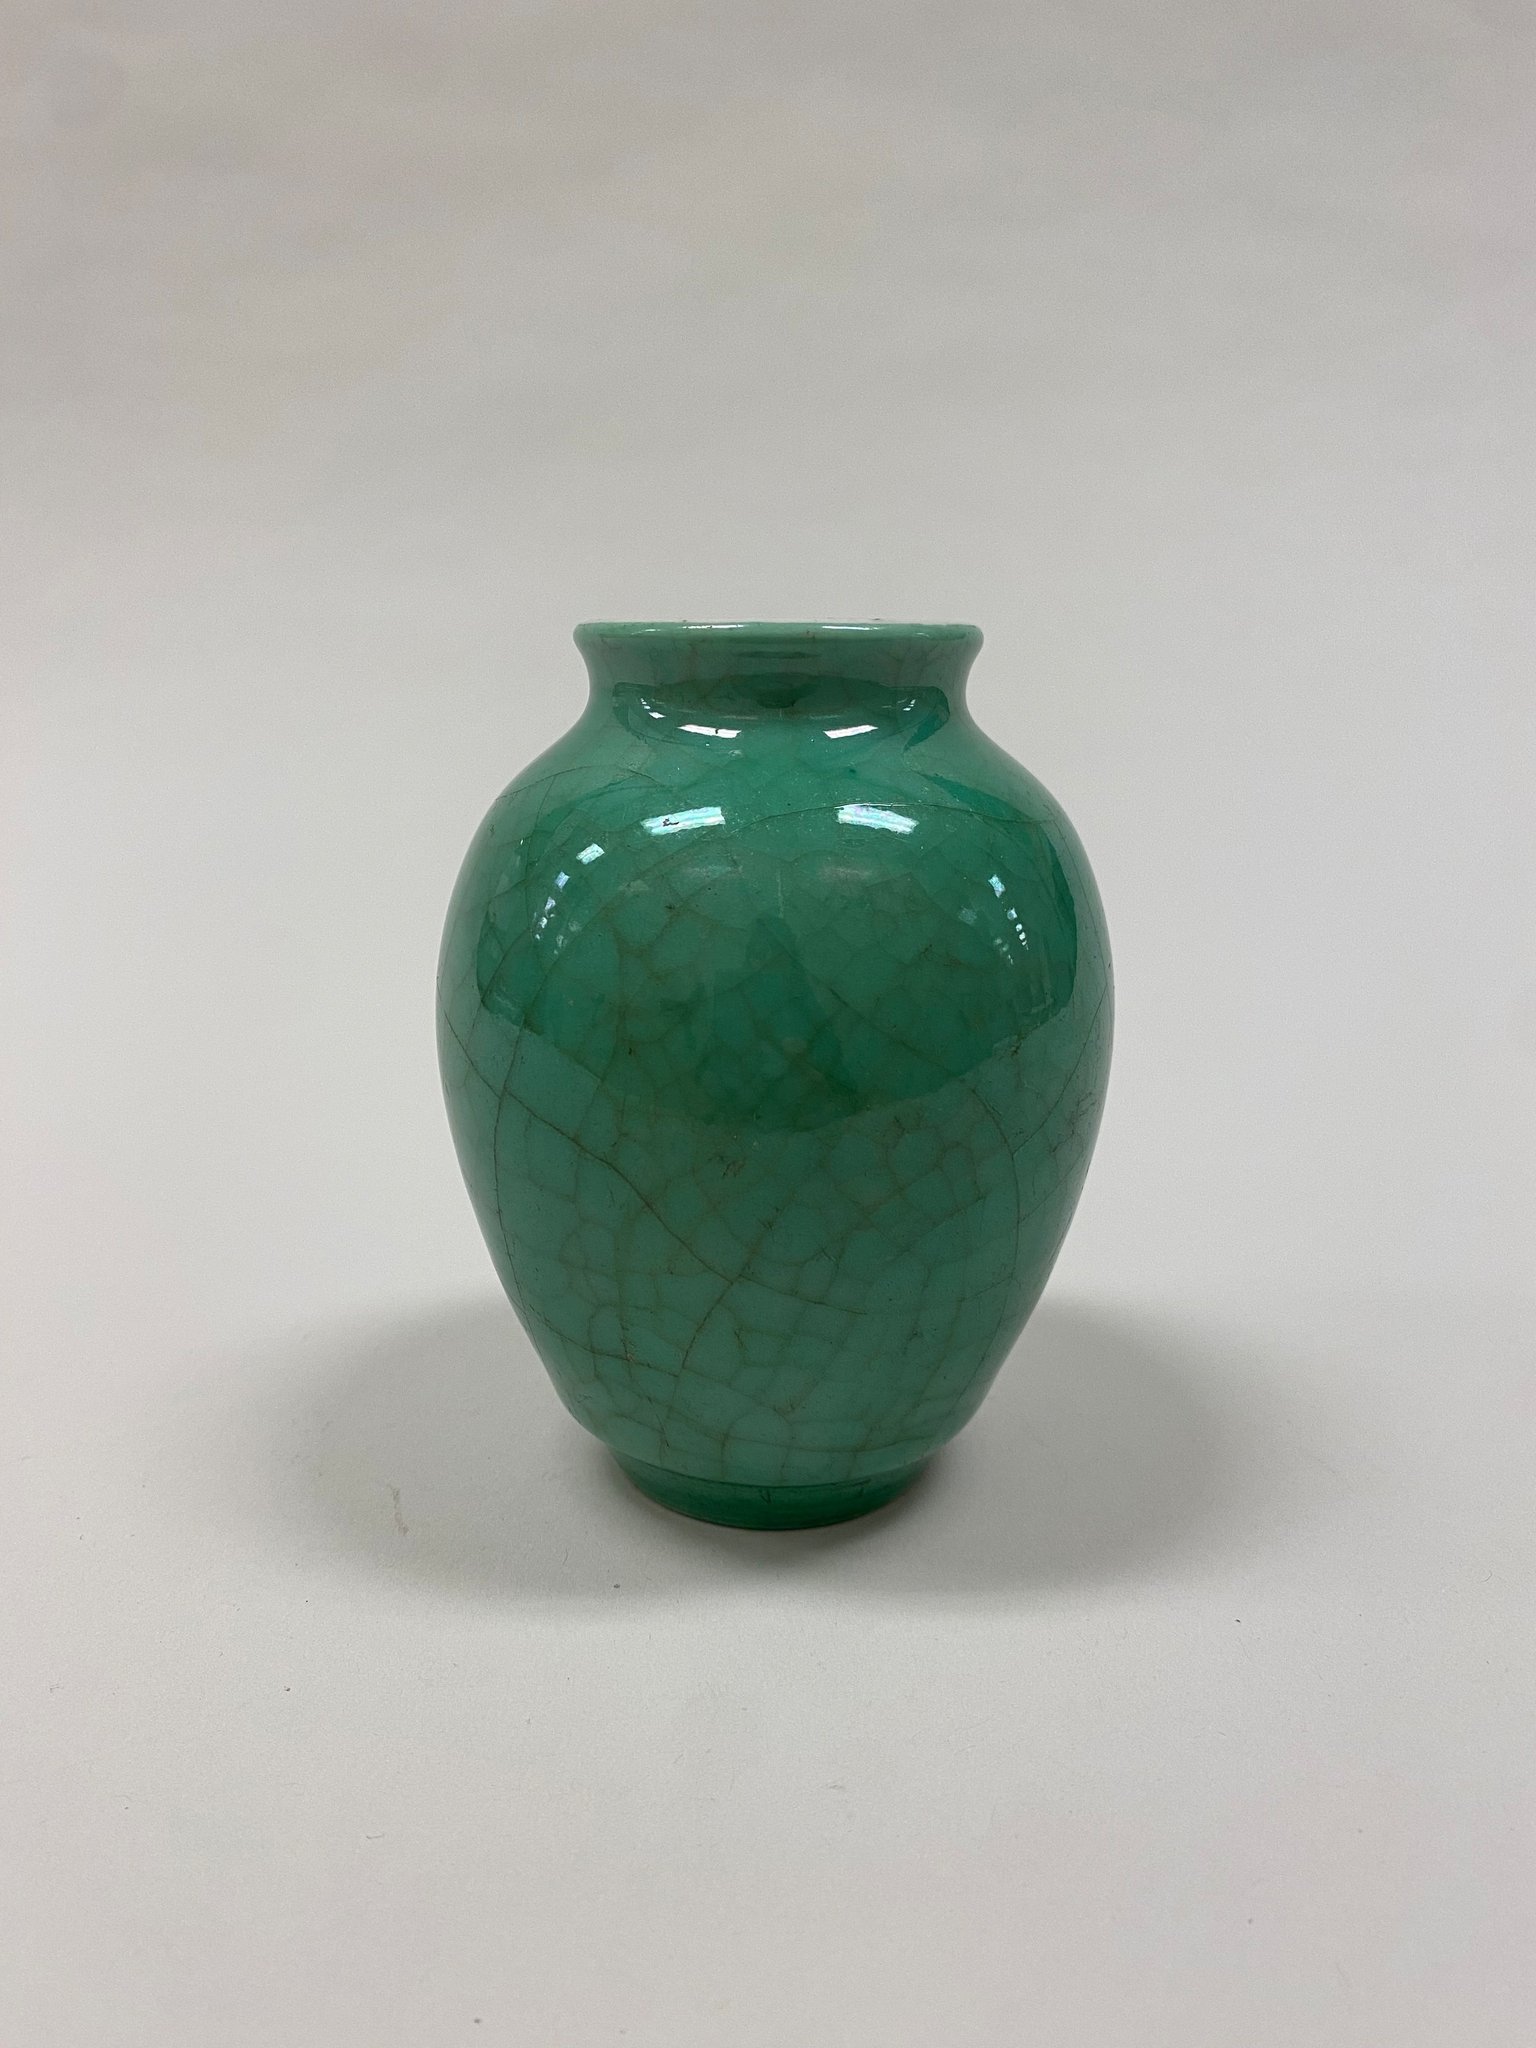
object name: jar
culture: chinese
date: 1701-1733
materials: glaze, porcelain